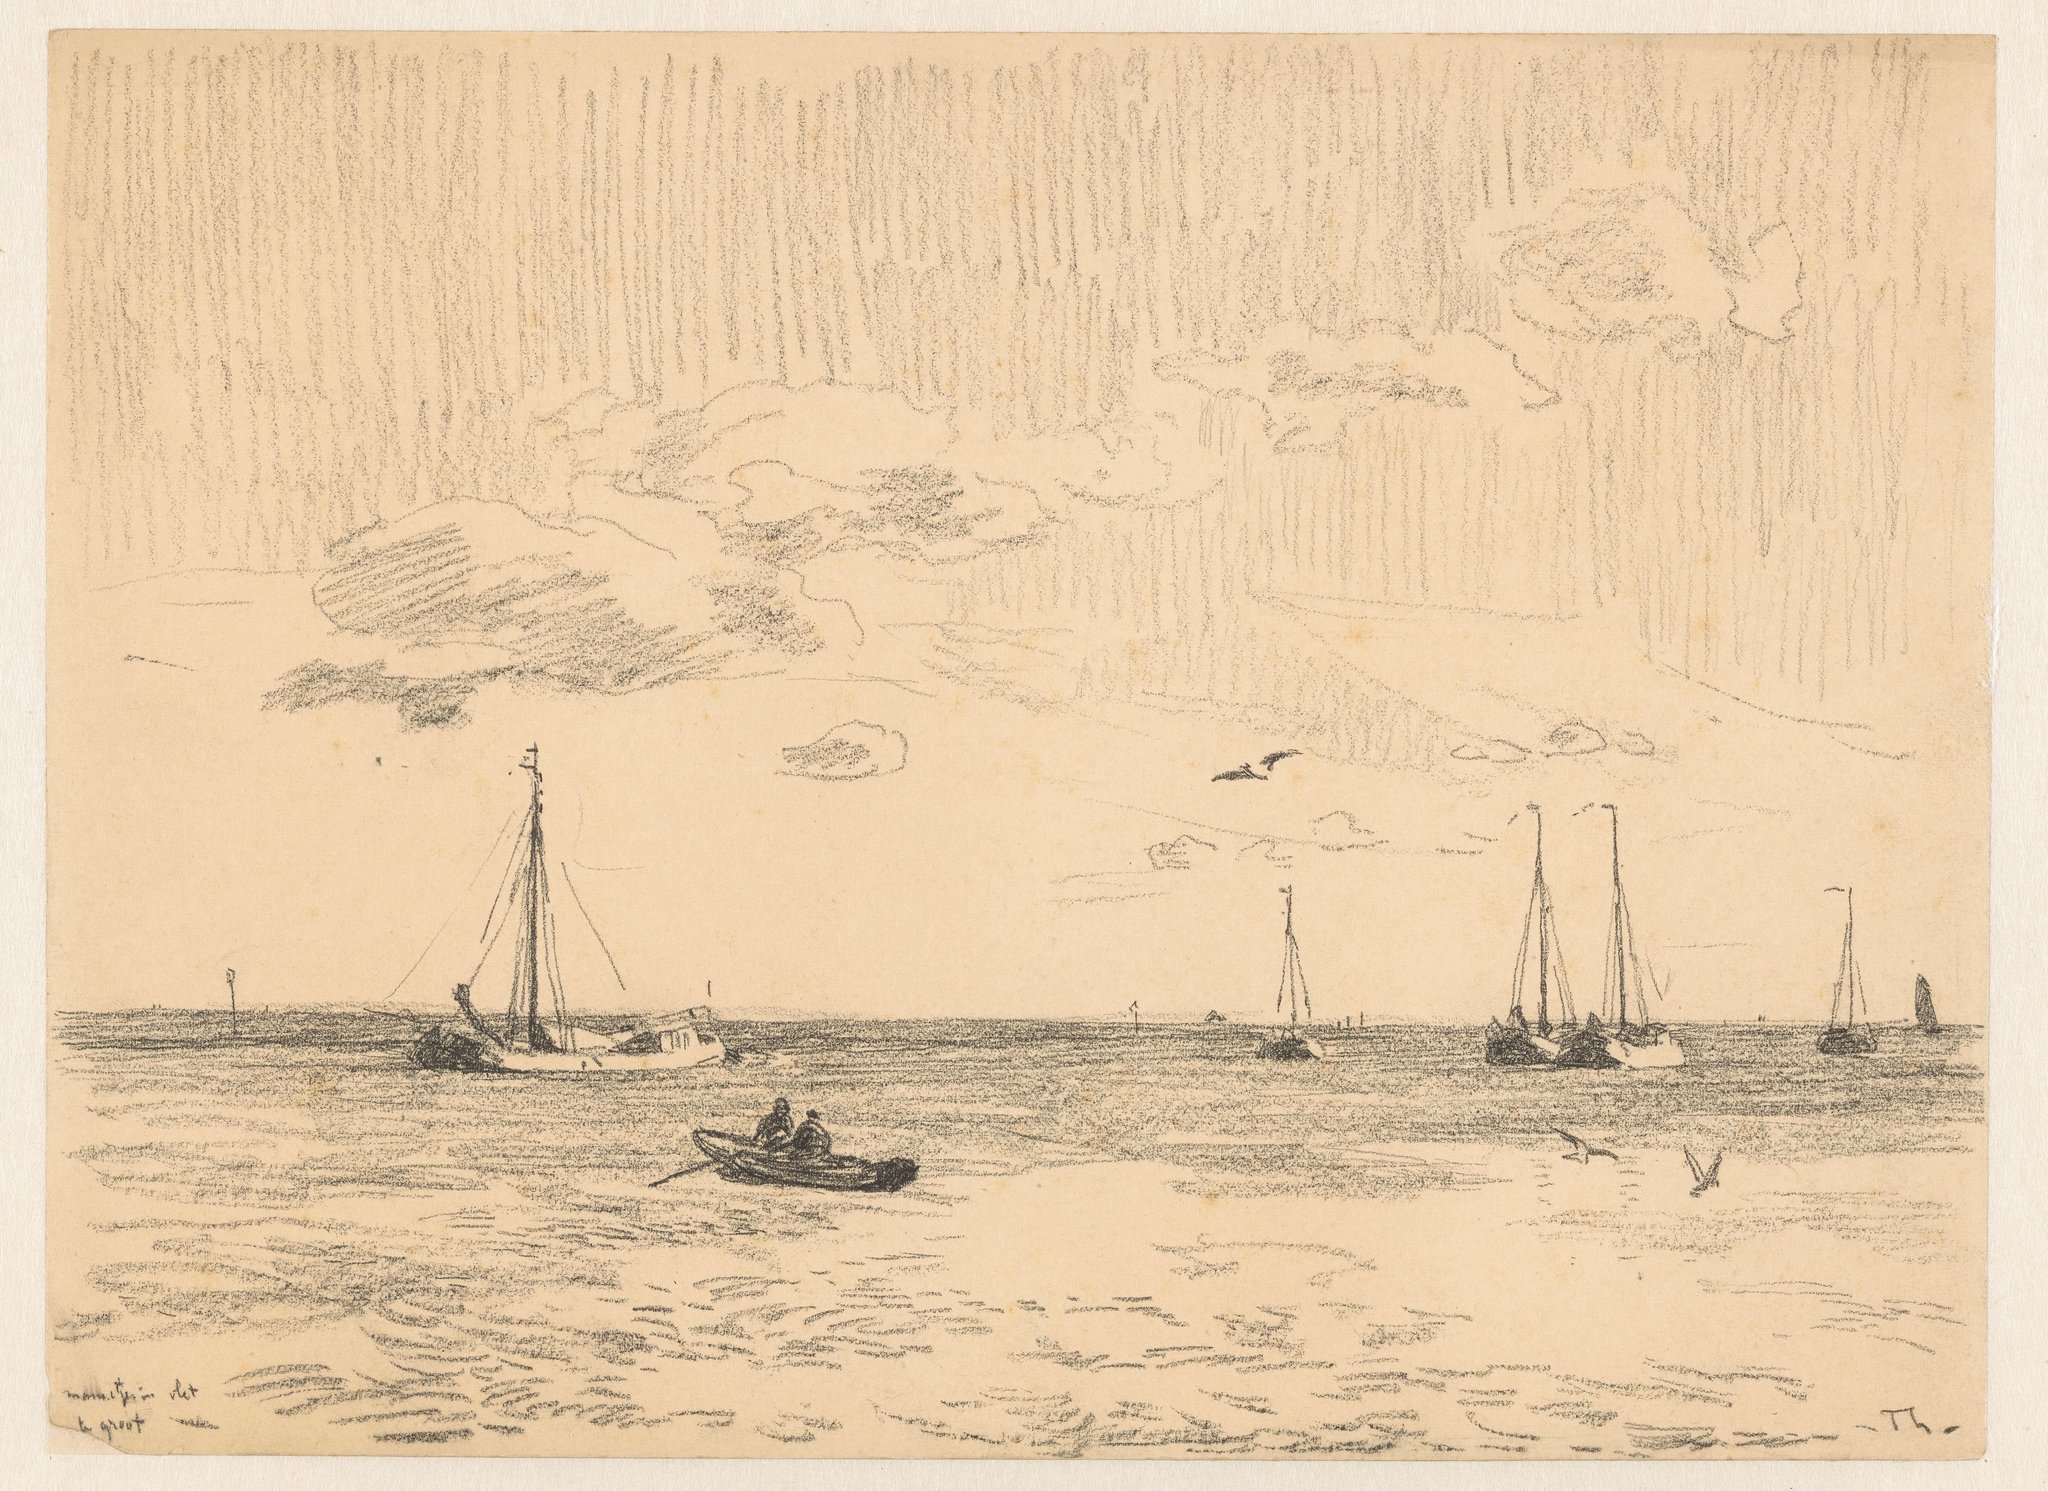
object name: drawing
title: Schepen voor anker met op de voorgrond een roeiboot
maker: willem bastiaan tholen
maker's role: draughtsman, painter, print maker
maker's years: 1860-1931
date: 1870-1931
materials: chalk, paper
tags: rowing-boat, canoe, etc., ships (in general) - cc - more than one ship